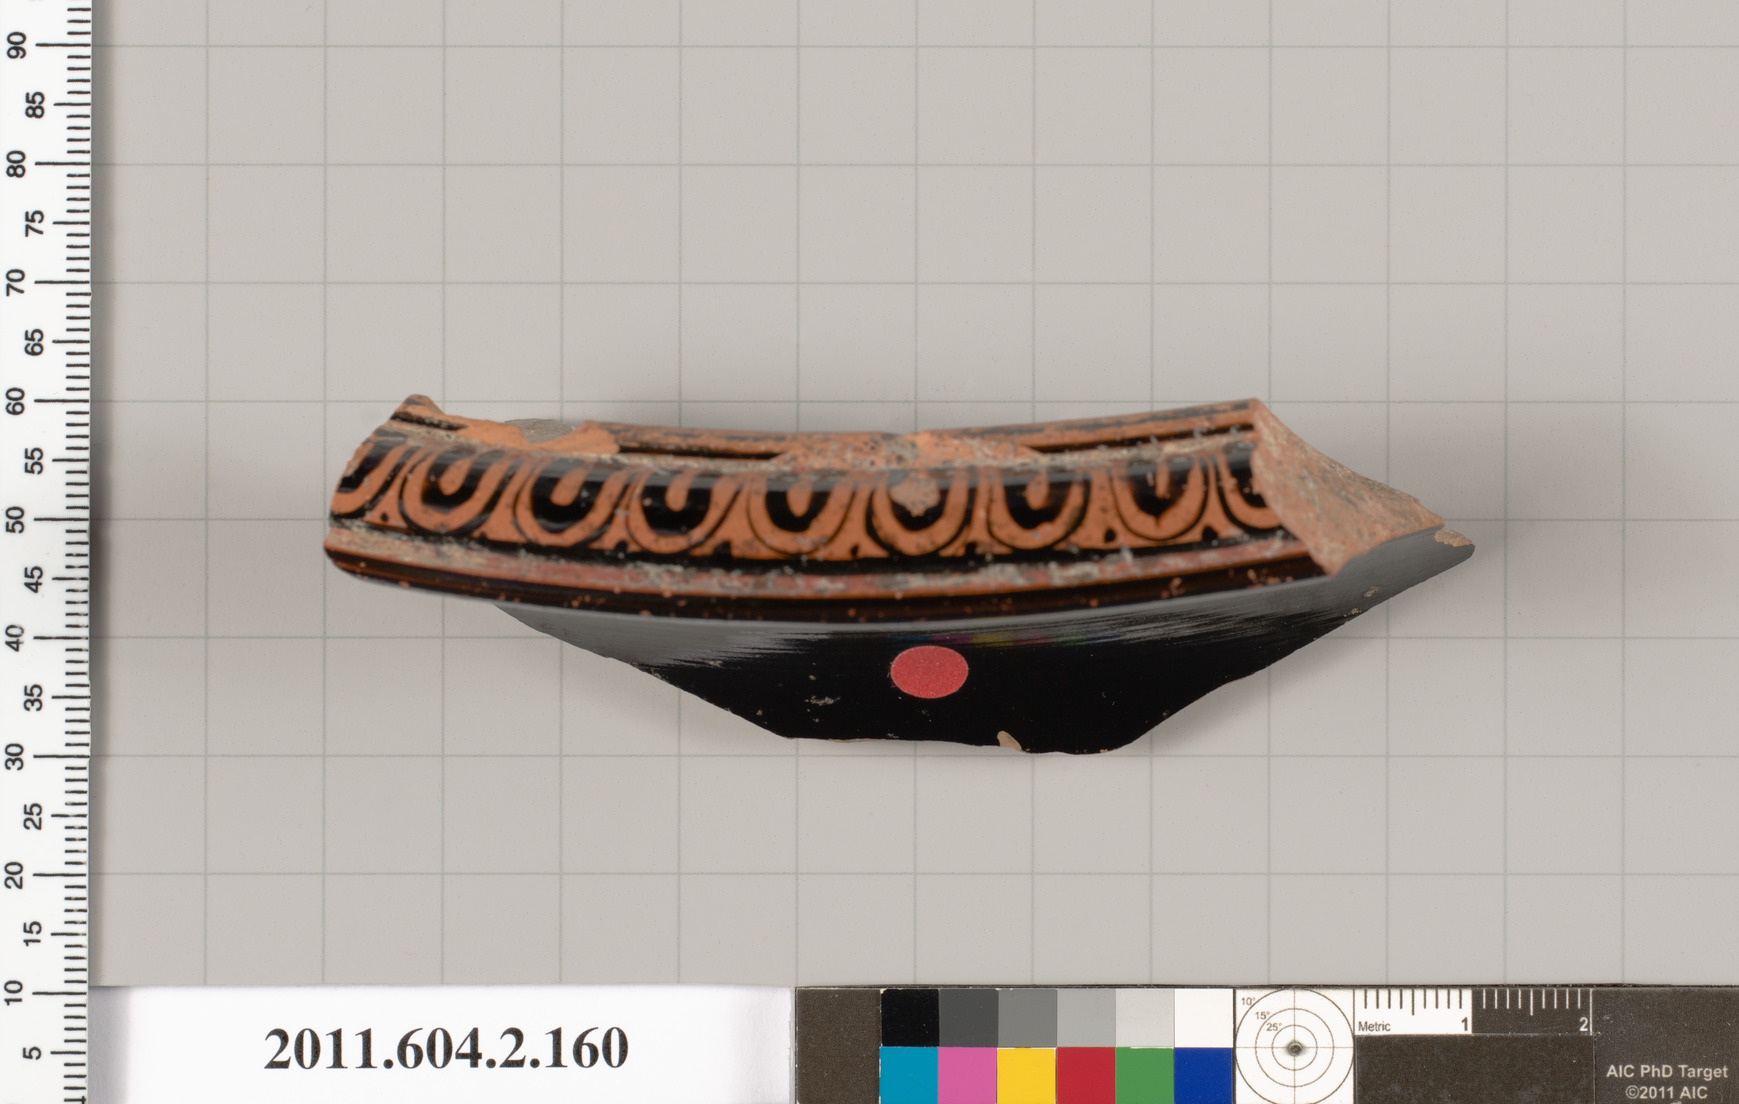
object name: stamnos fragment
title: Terracotta fragment of a stamnos (jar)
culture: greek, attic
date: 450-430 BCE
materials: terracotta